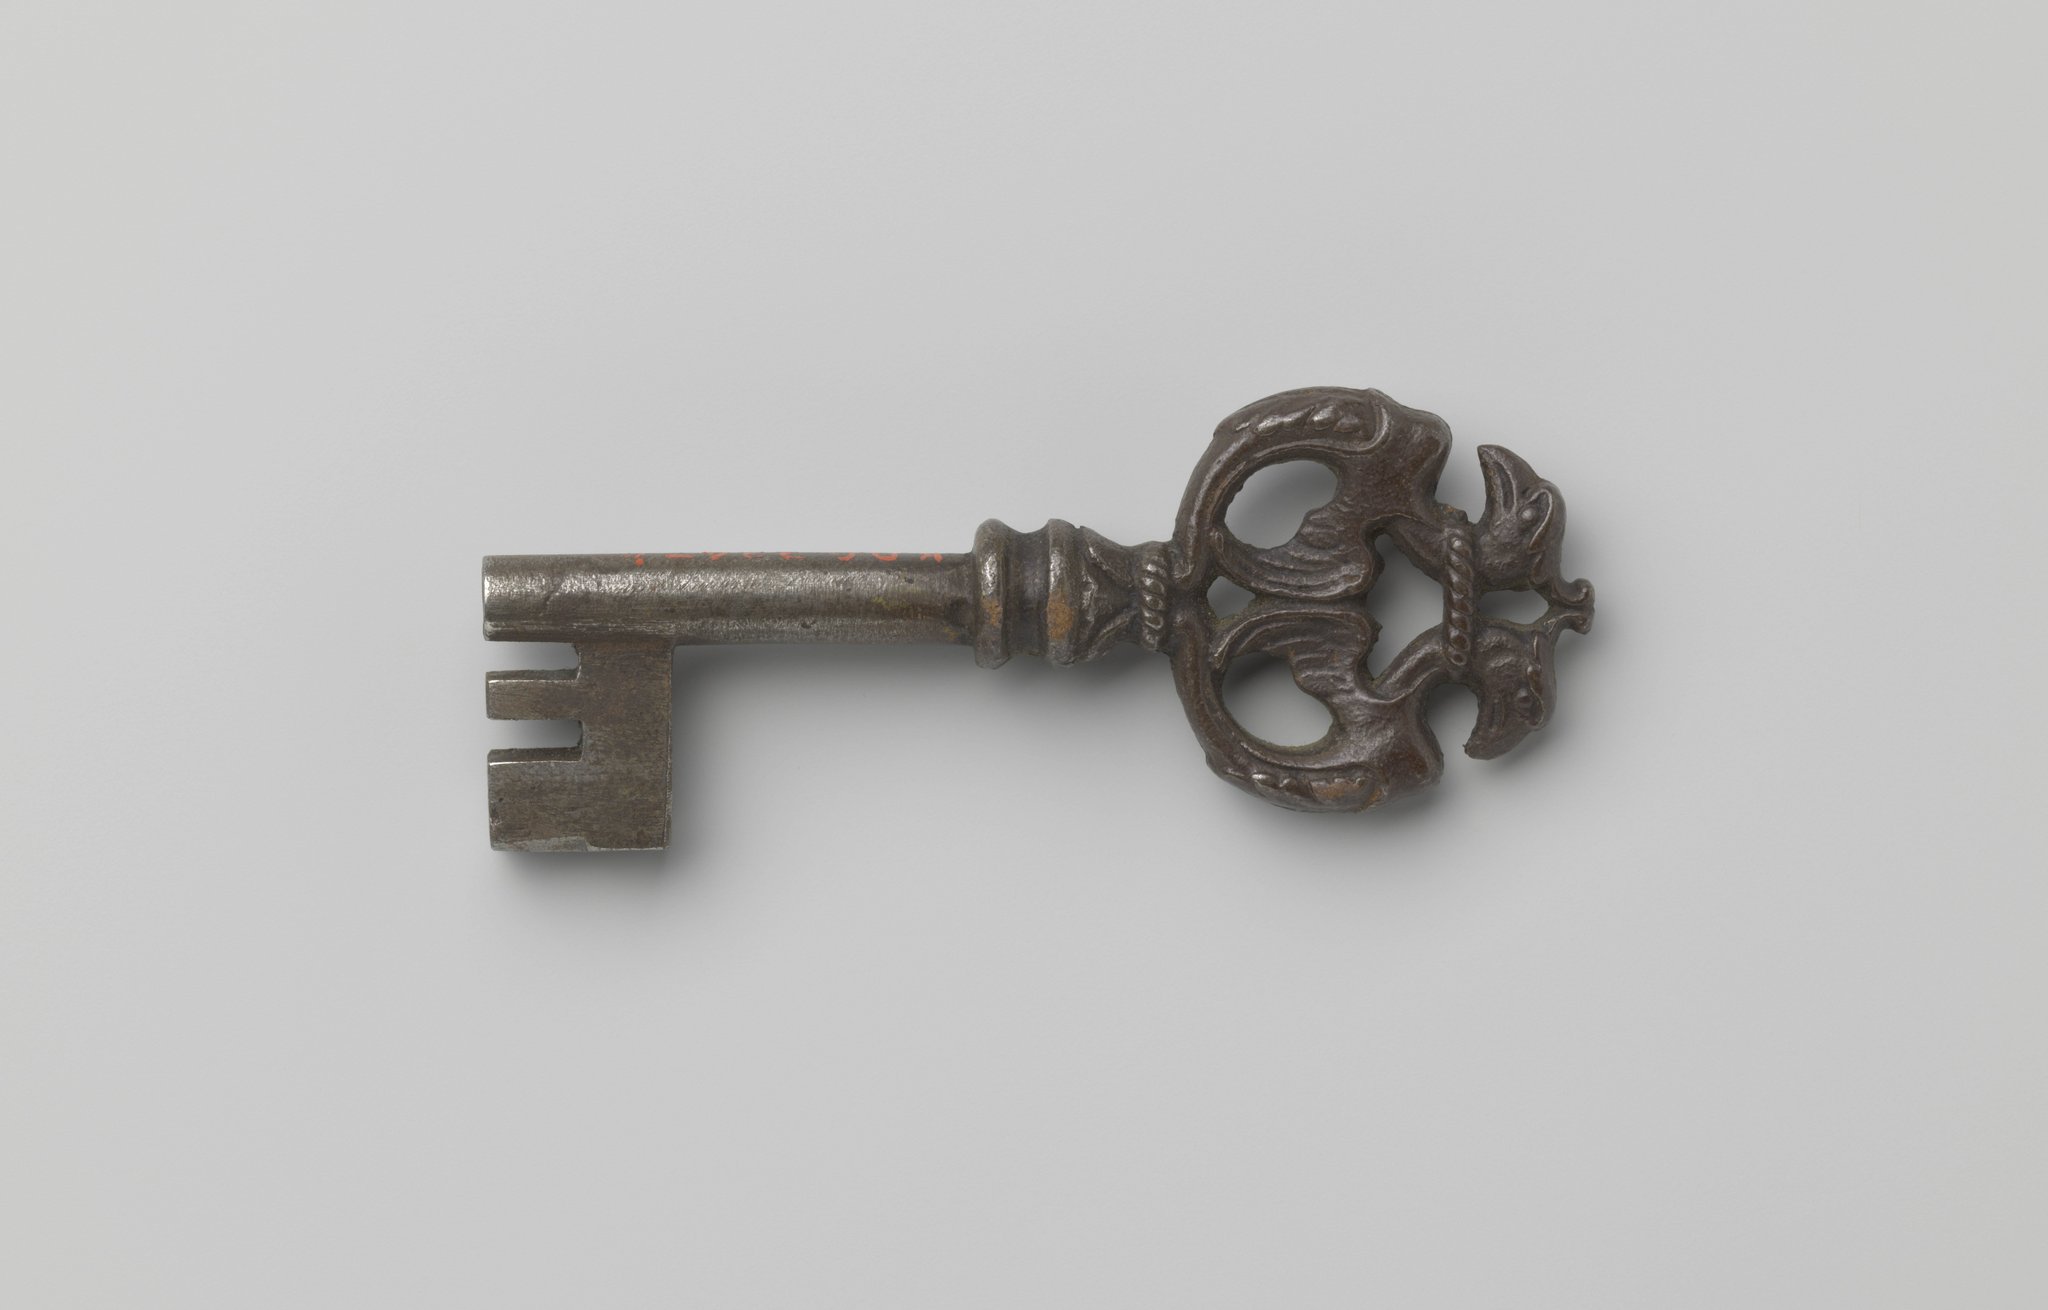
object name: pipe key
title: Pijpsleutel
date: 1600-1699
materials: iron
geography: france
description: Pijpsleutel waarvan de greep bestaat uit twee ruglings geplaatste en door twee koortjes verbonden gestileerde griffioenen.